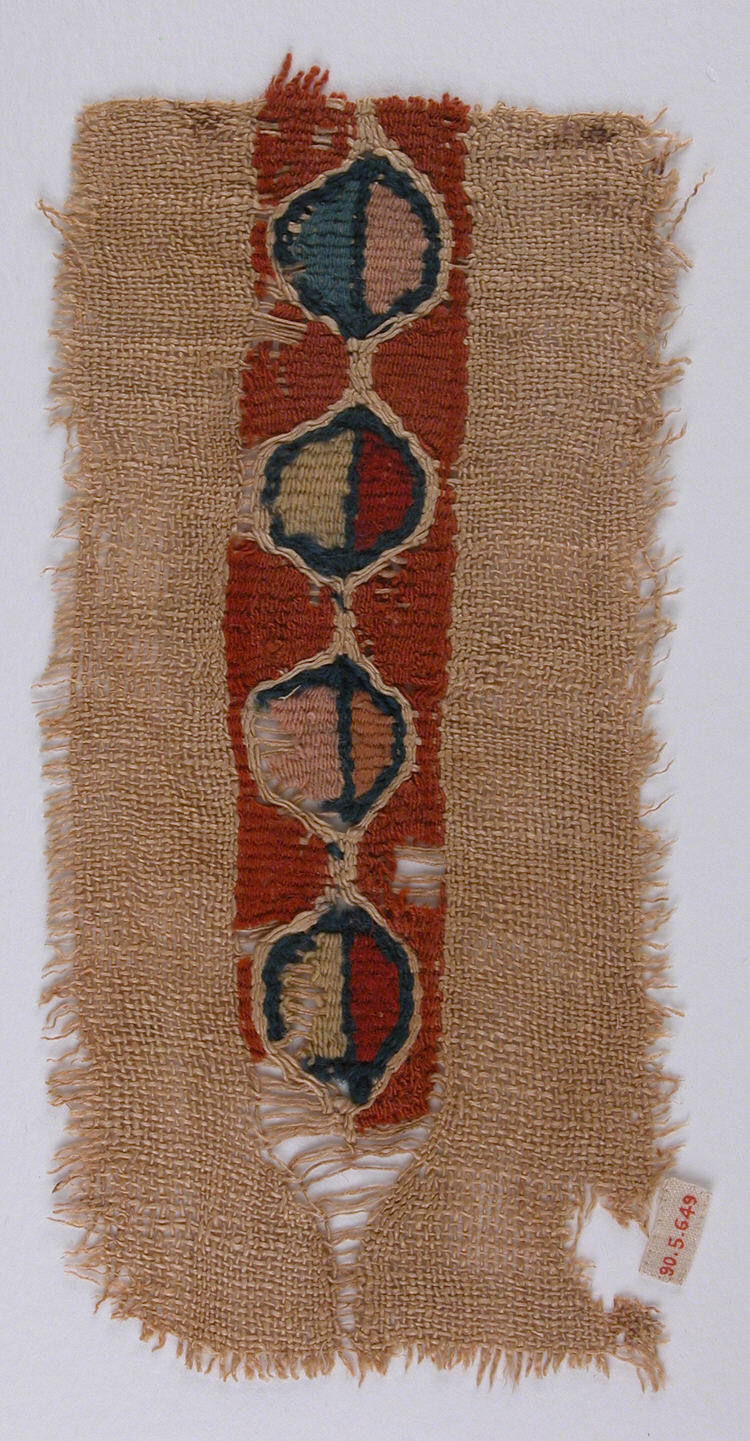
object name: textile fragment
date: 401-600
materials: linen, wool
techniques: weave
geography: egypt